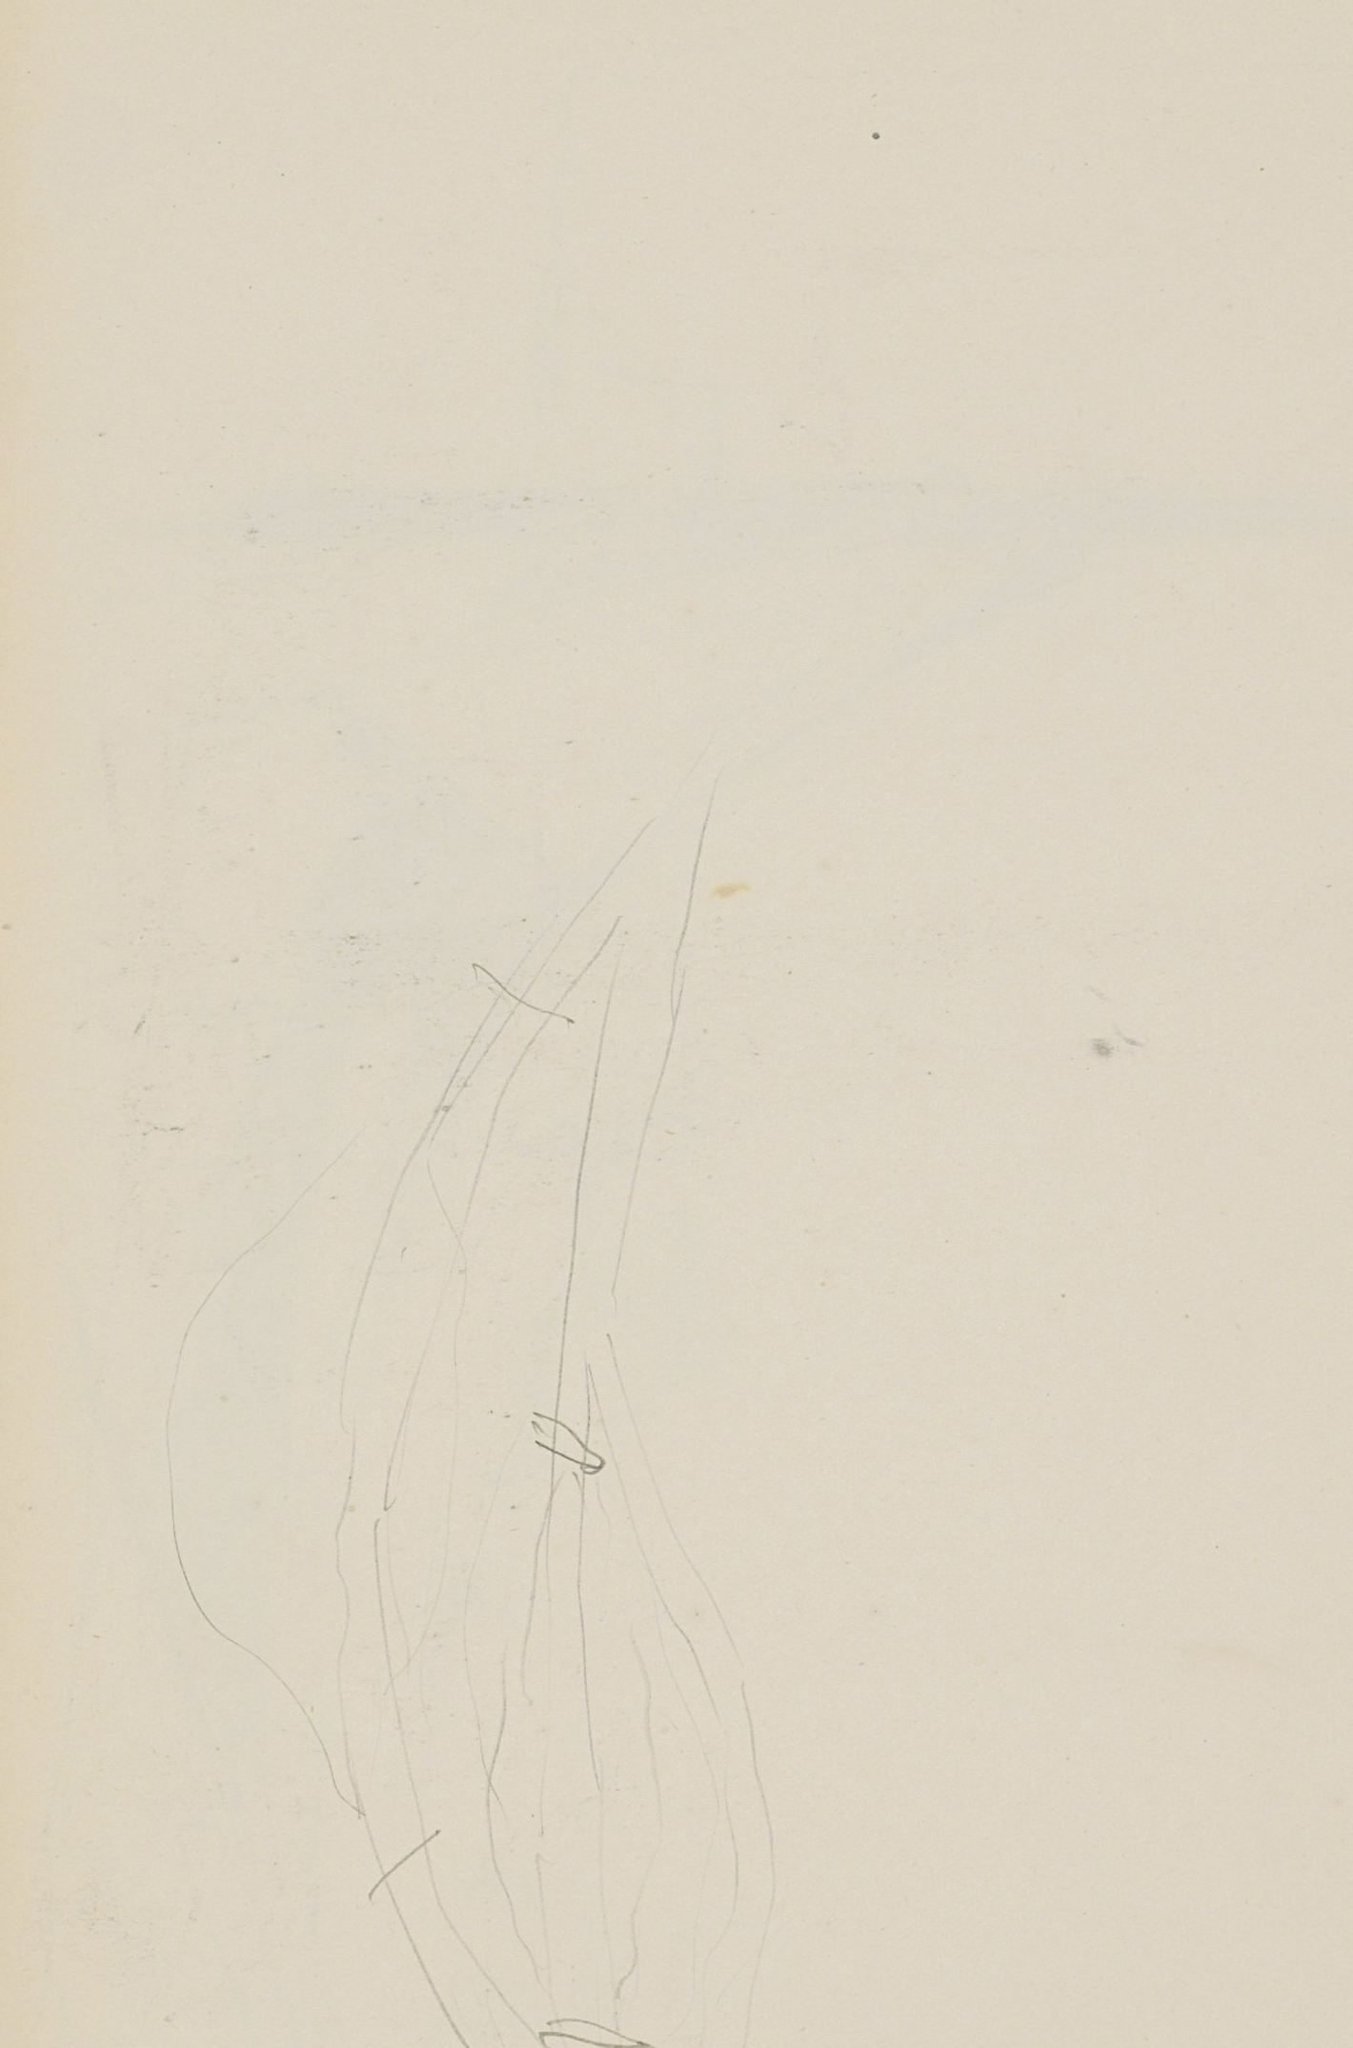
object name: sketchbook leaf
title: Studie, mogelijk een roeiboot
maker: cornelis vreedenburgh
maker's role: draughtsman, print maker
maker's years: 1880-1946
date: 1890-1946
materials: paper, pencil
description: Blad 32 verso uit een schetsboek met 59 bladen.